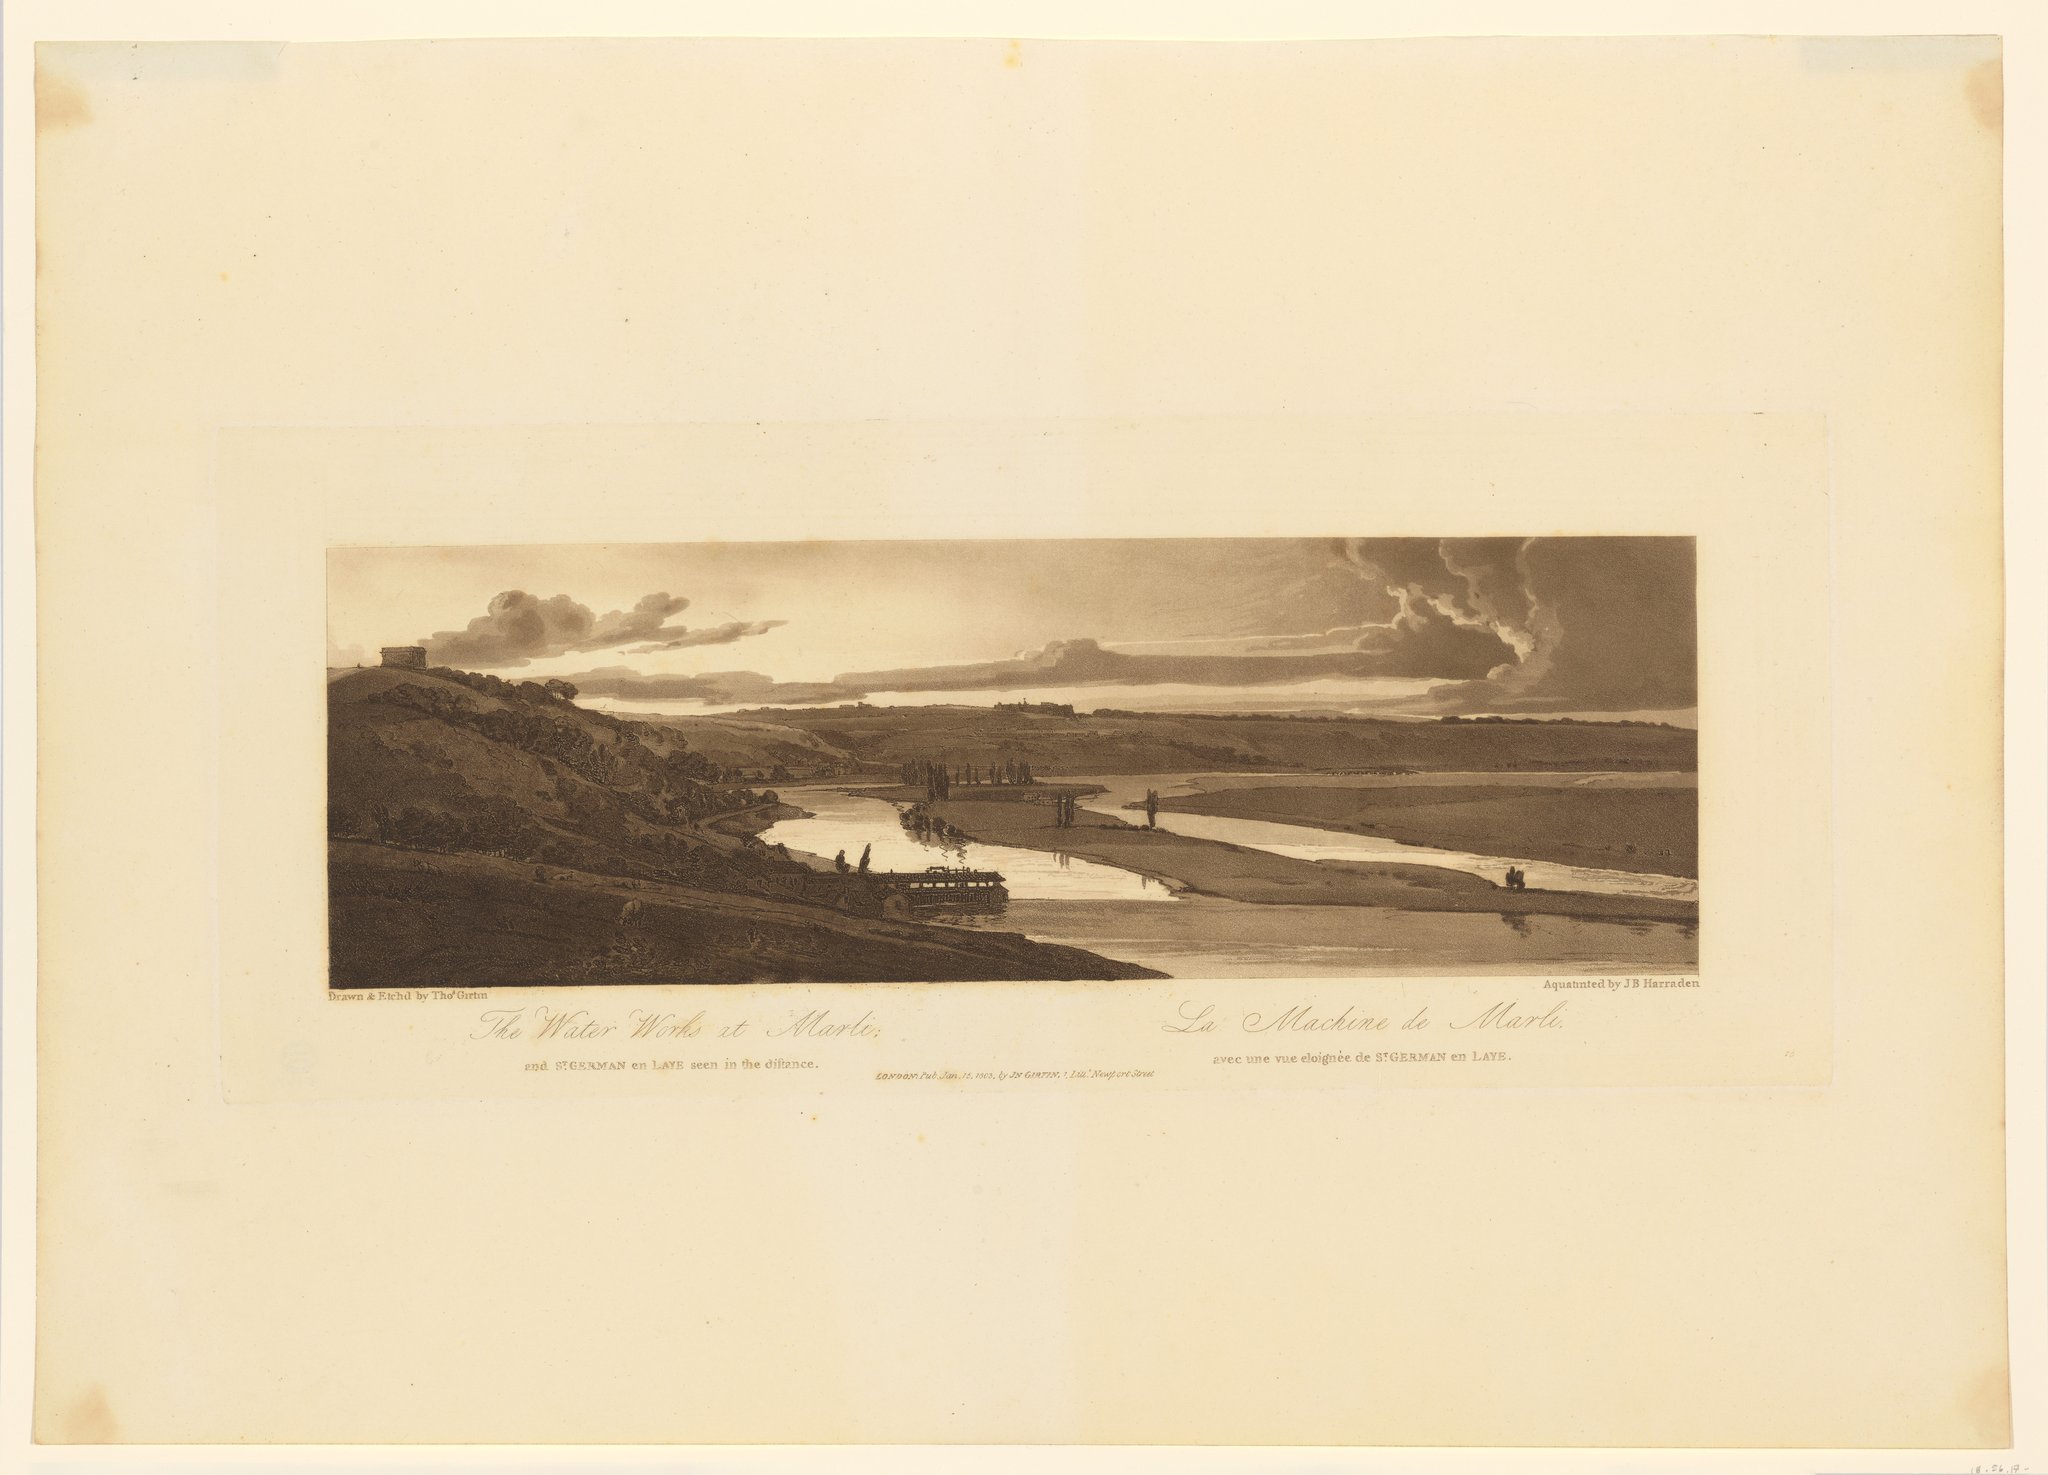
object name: print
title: The Waterworks at Marli, and St. German en Laye seen in the distance (La Machine de Marli, avec une vue eloignée de St. German en Laye)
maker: thomas girtin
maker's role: artist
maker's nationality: british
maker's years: 1775-1802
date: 1803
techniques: aquatint, etching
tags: rivers,landscapes